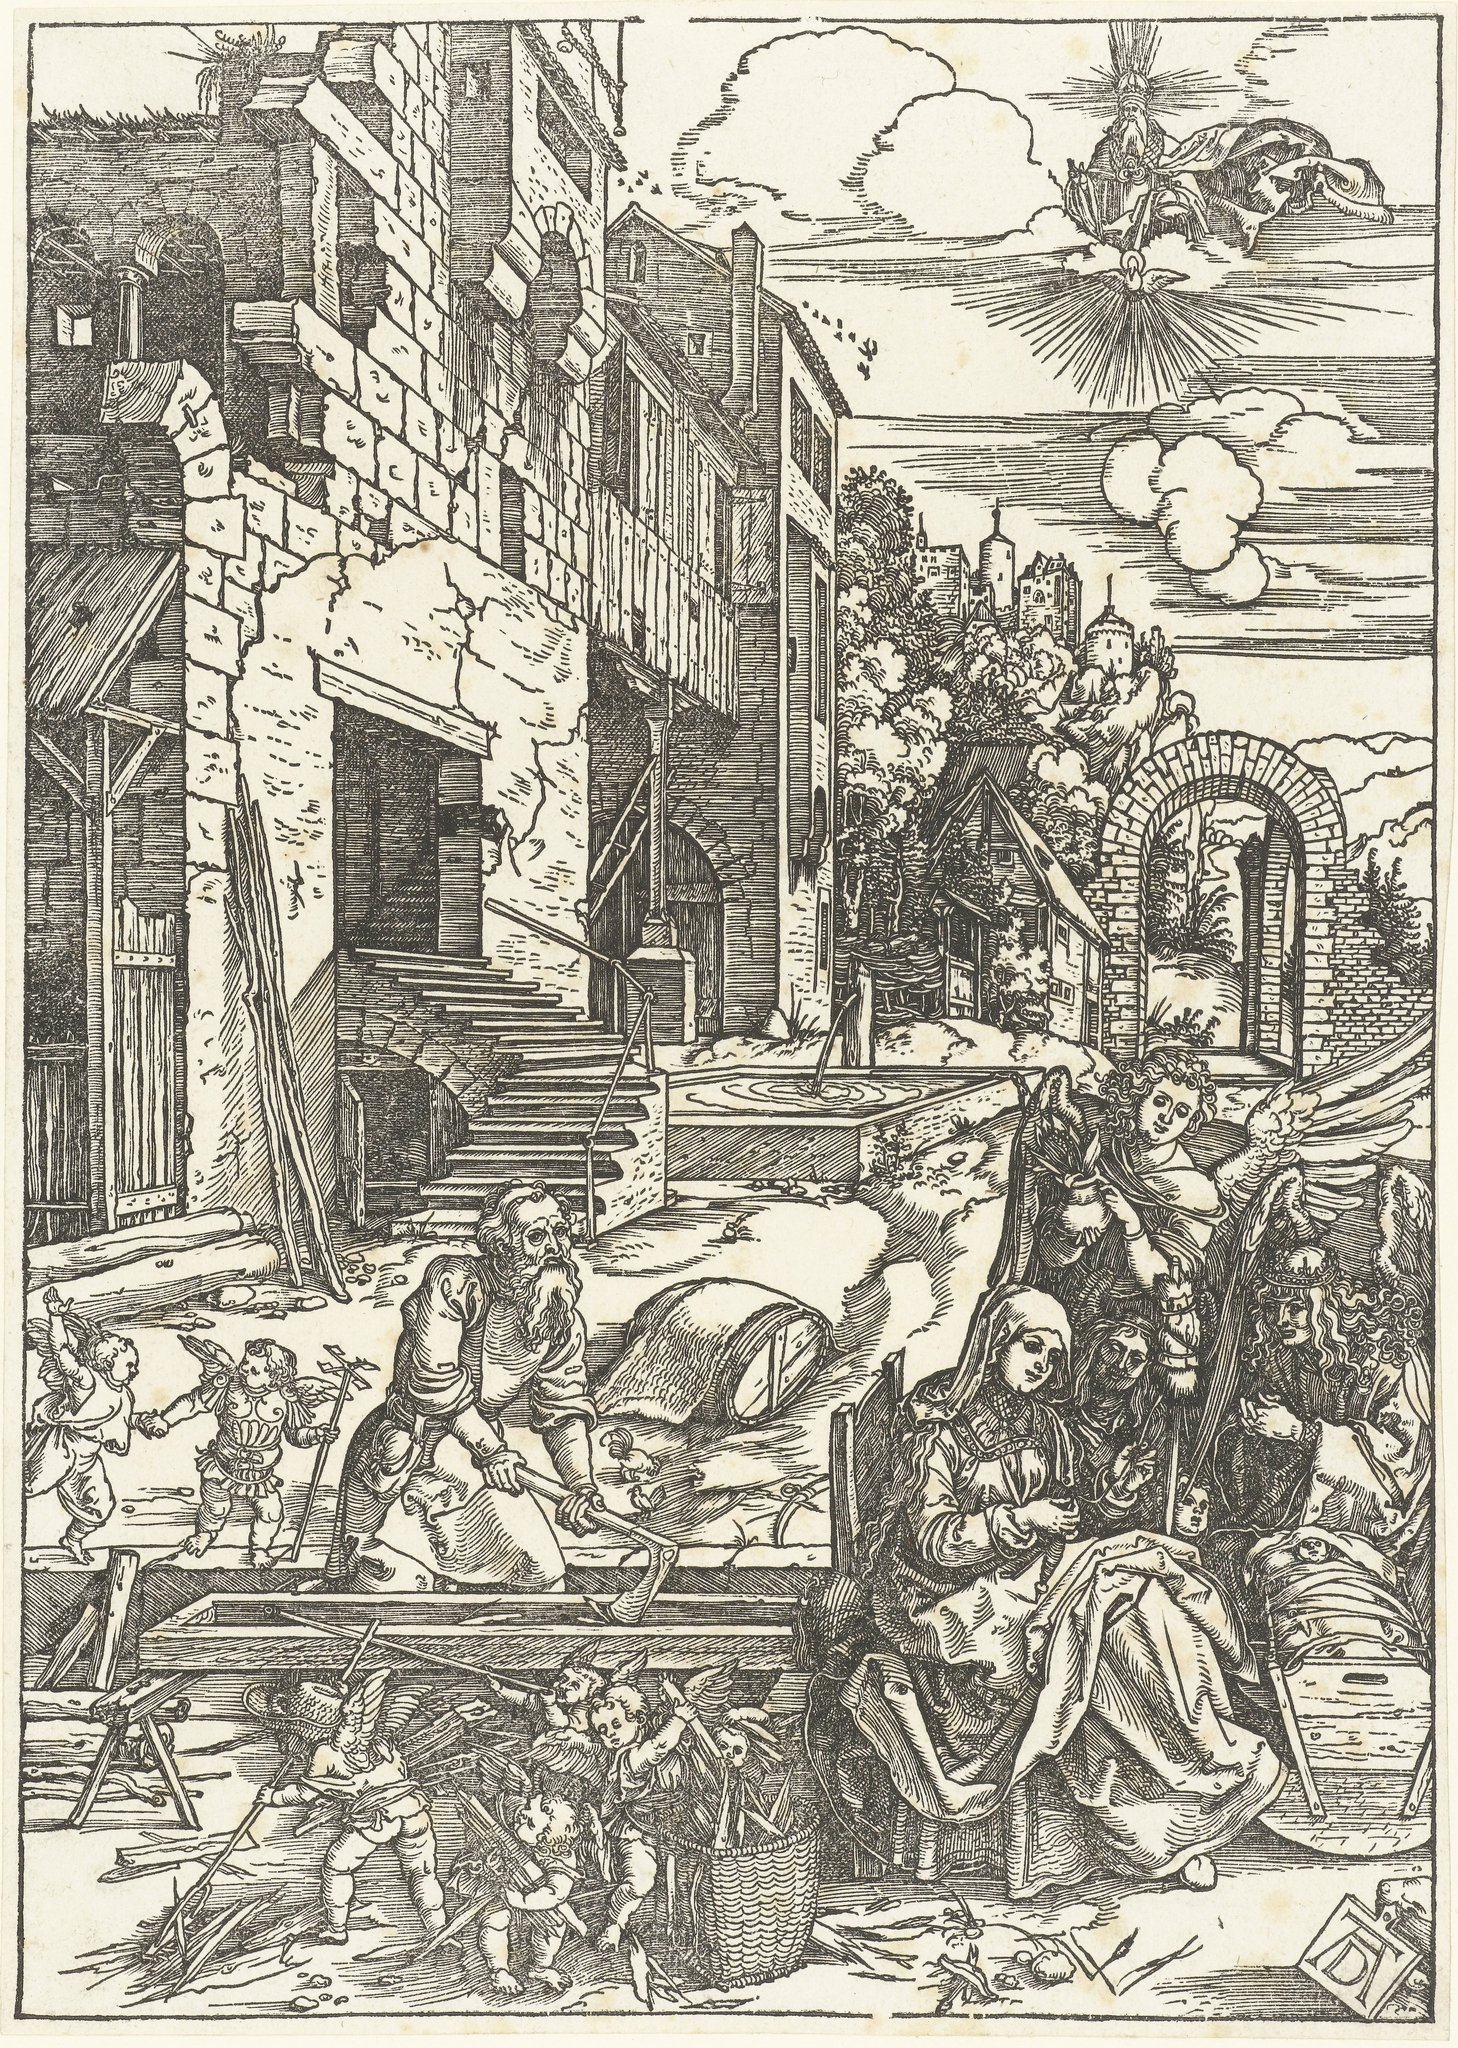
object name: print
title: Leven van Maria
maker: albrecht dürer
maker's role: draughtsman, painter, print maker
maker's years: 1471-1528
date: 1500-1504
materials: paper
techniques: woodcut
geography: nuremberg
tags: stay of the holy family in egypt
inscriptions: inscription: ‘Geoffreerd aan de Teken Akademie / der stadt Amsterdam / 1788 P...’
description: Voor een vervallen gebouw zit Maria naast enkele engelen te spinnen, terwijl ze met de voet het bedje waarin het Christuskind ligt laat wiegen. Achter haar werkt Jozef aan een trog, geholpen door putti. Deze prent is onderdeel van een serie van 20 prenten, bestaand uit een titelprent en 19 prenten met scènes uit het leven van Maria.